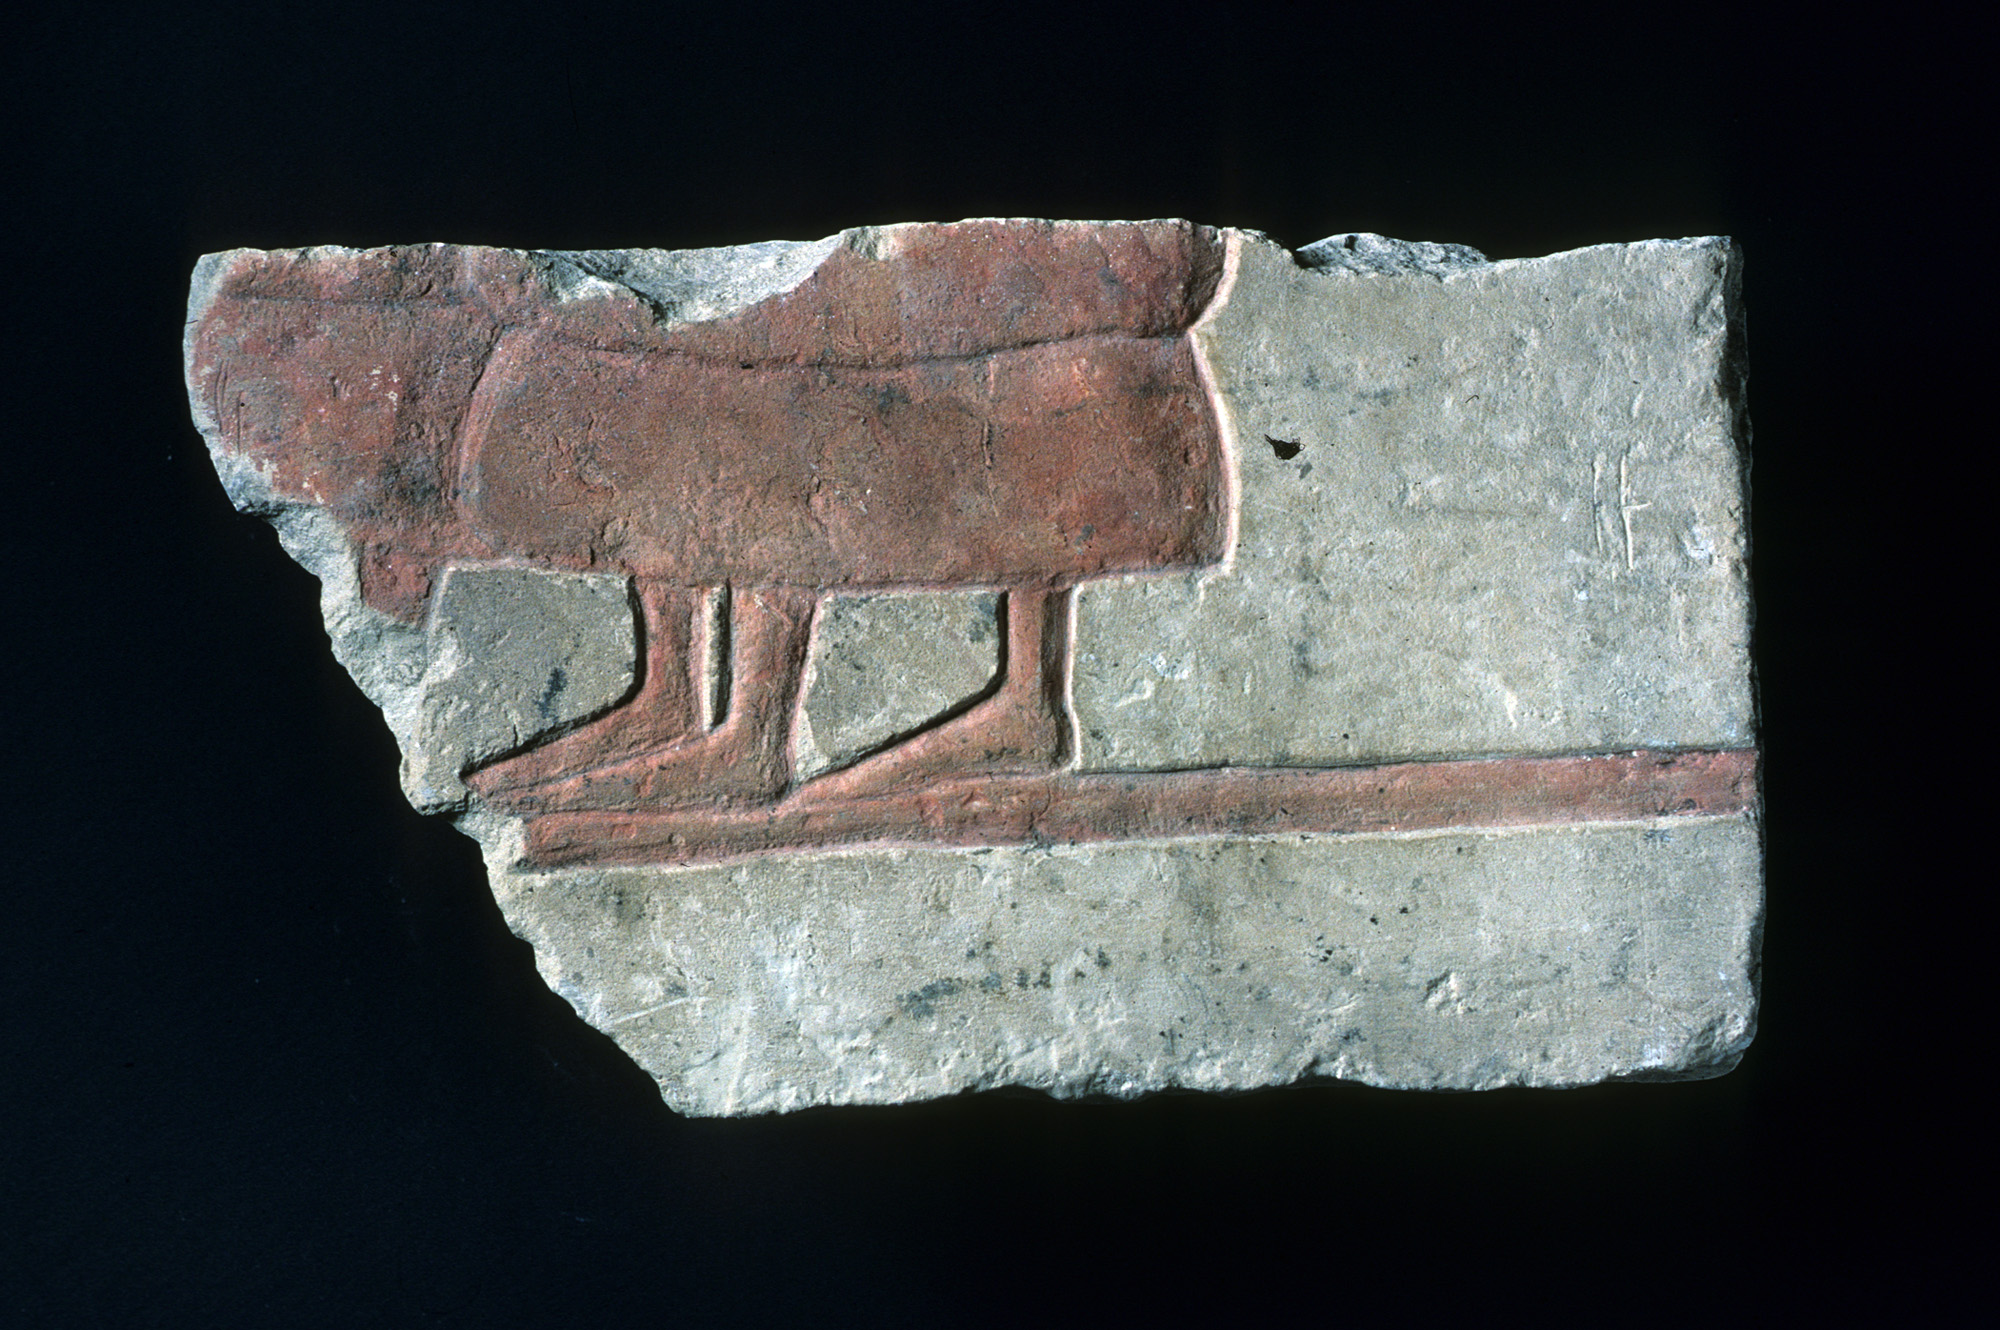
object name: talatat, foreigner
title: Relief with two foreigners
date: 1353-1336 BCE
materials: limestone, paint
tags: feet